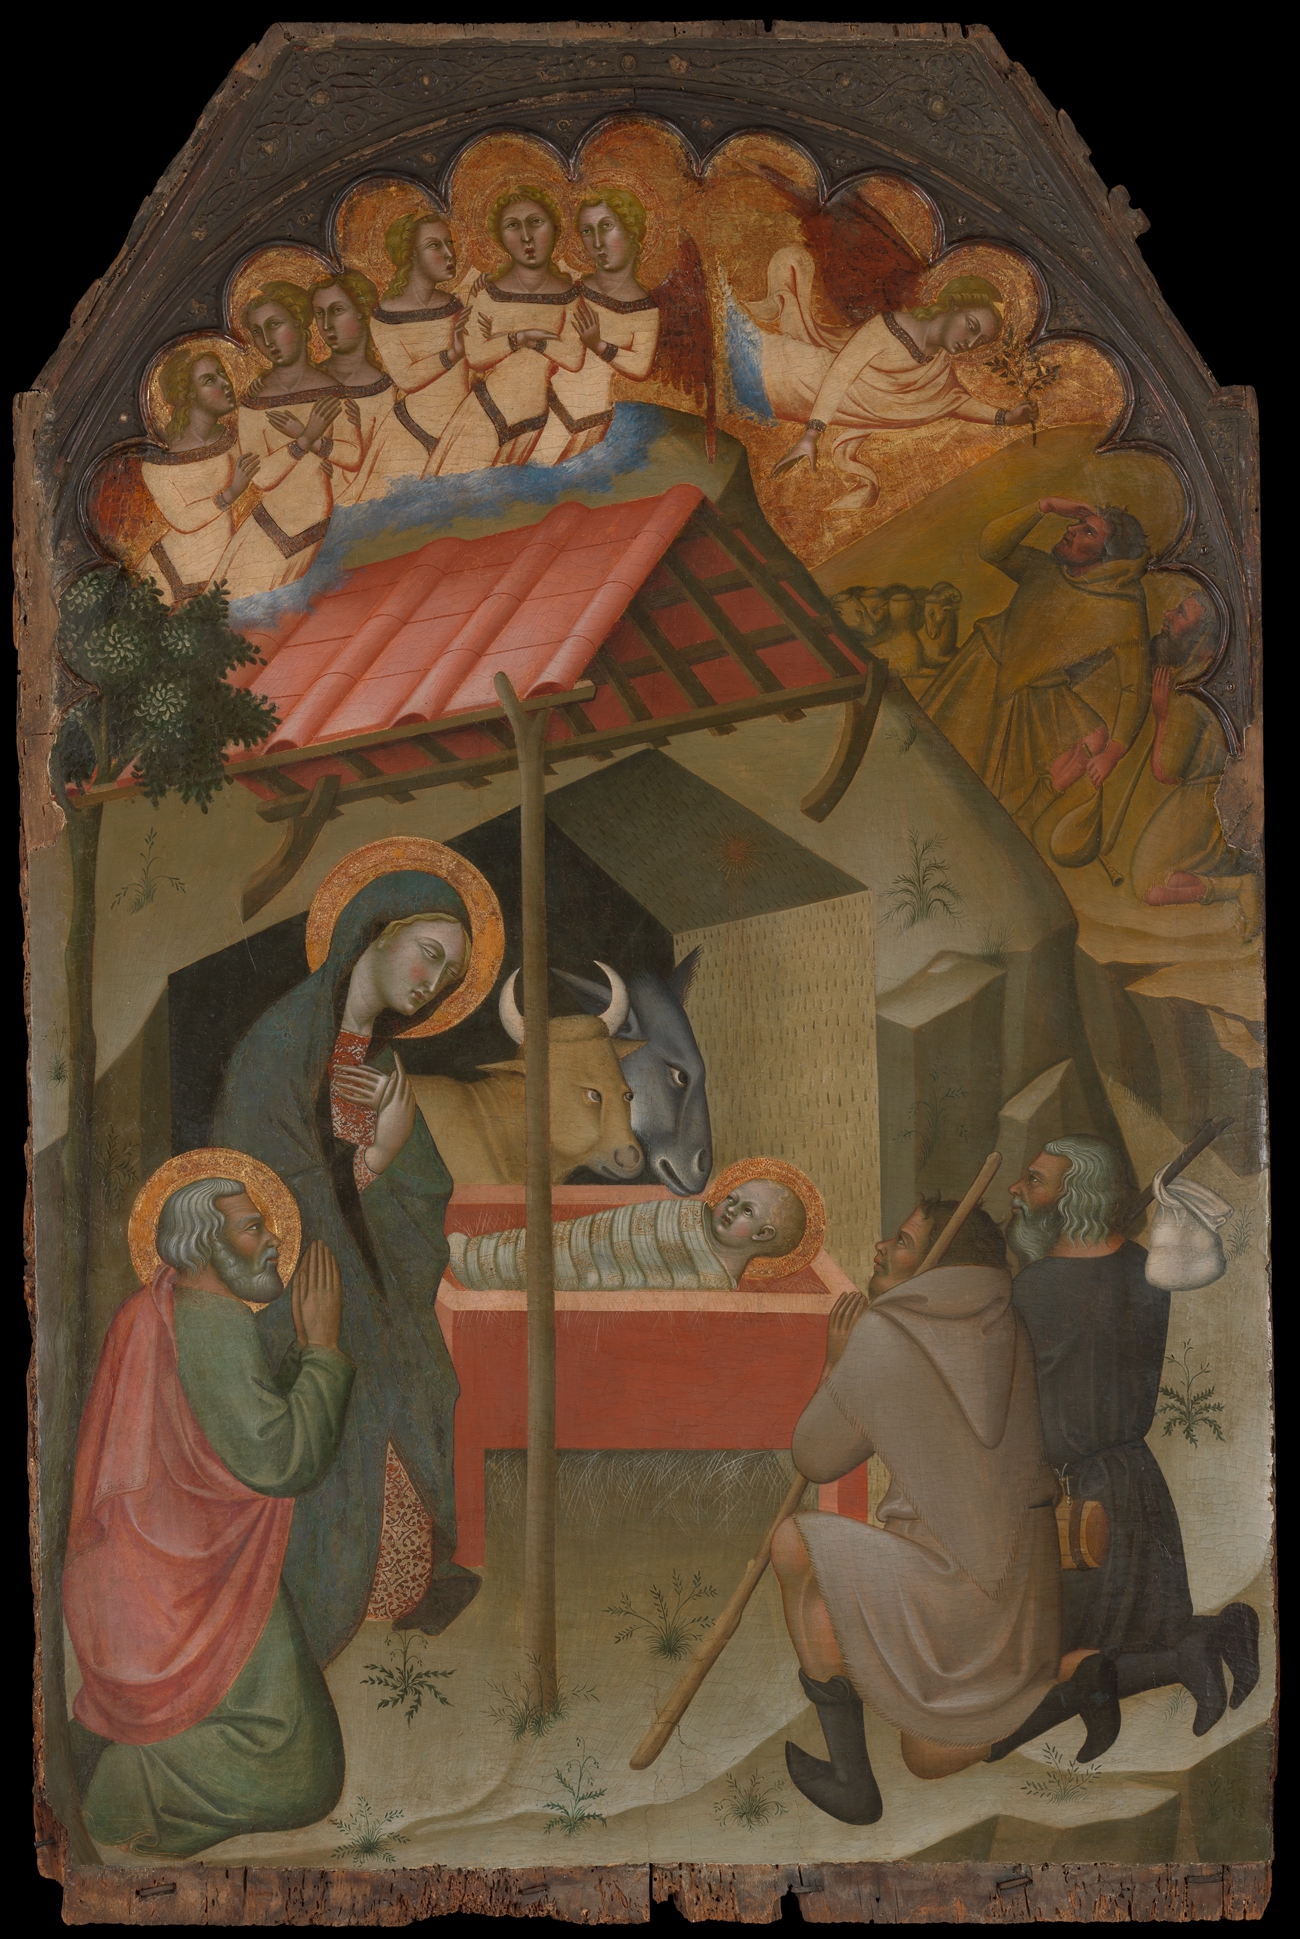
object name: painting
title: The Adoration of the Shepherds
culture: italian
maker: bartolo di fredi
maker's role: artist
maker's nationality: italian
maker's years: 1353-1410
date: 1374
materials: gold leaf, wood, paint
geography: italy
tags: cows,angels,saint joseph,virgin mary,jesus,adoration of the shepherds